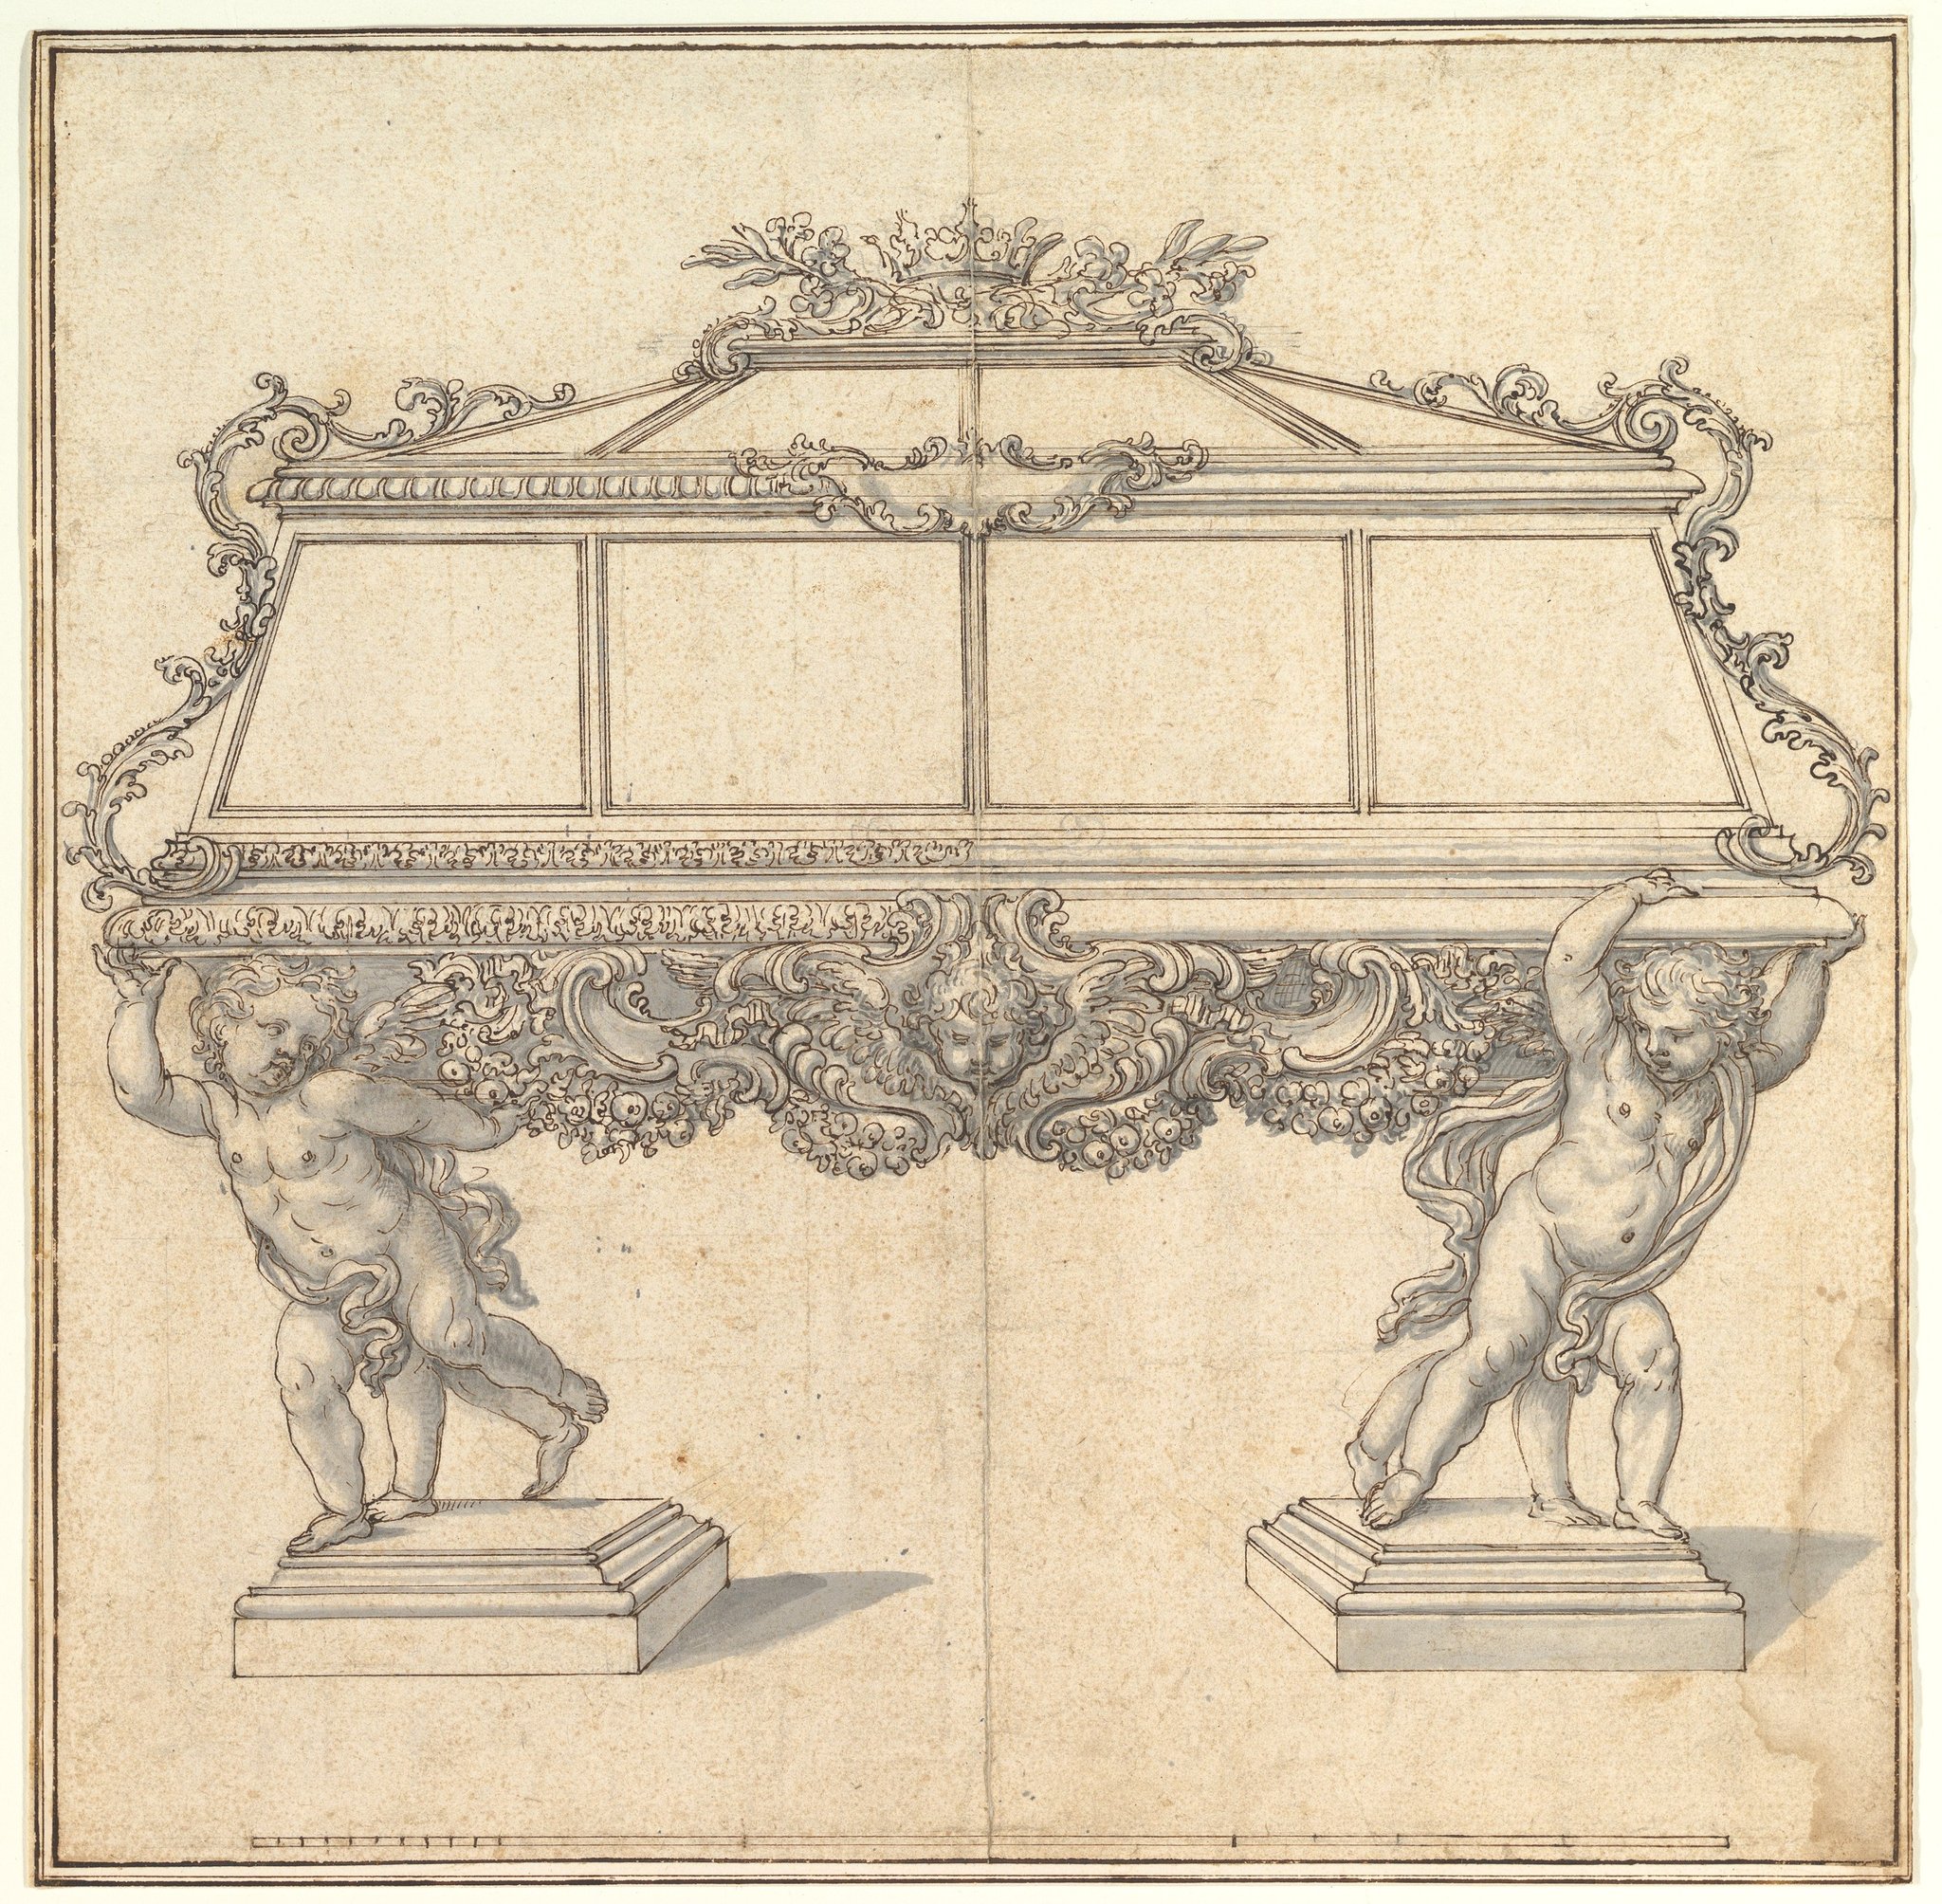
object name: drawing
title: Design for a Sarcophagus Supported by Putti for the Church of S. Maria Maddalena de' Pazzi, Florence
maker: giovanni battista foggini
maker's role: artist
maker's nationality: italian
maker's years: 1652-1725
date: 1652-1725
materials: chalk, graphite, ink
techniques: brush, pen, wash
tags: putti,sarcophagus